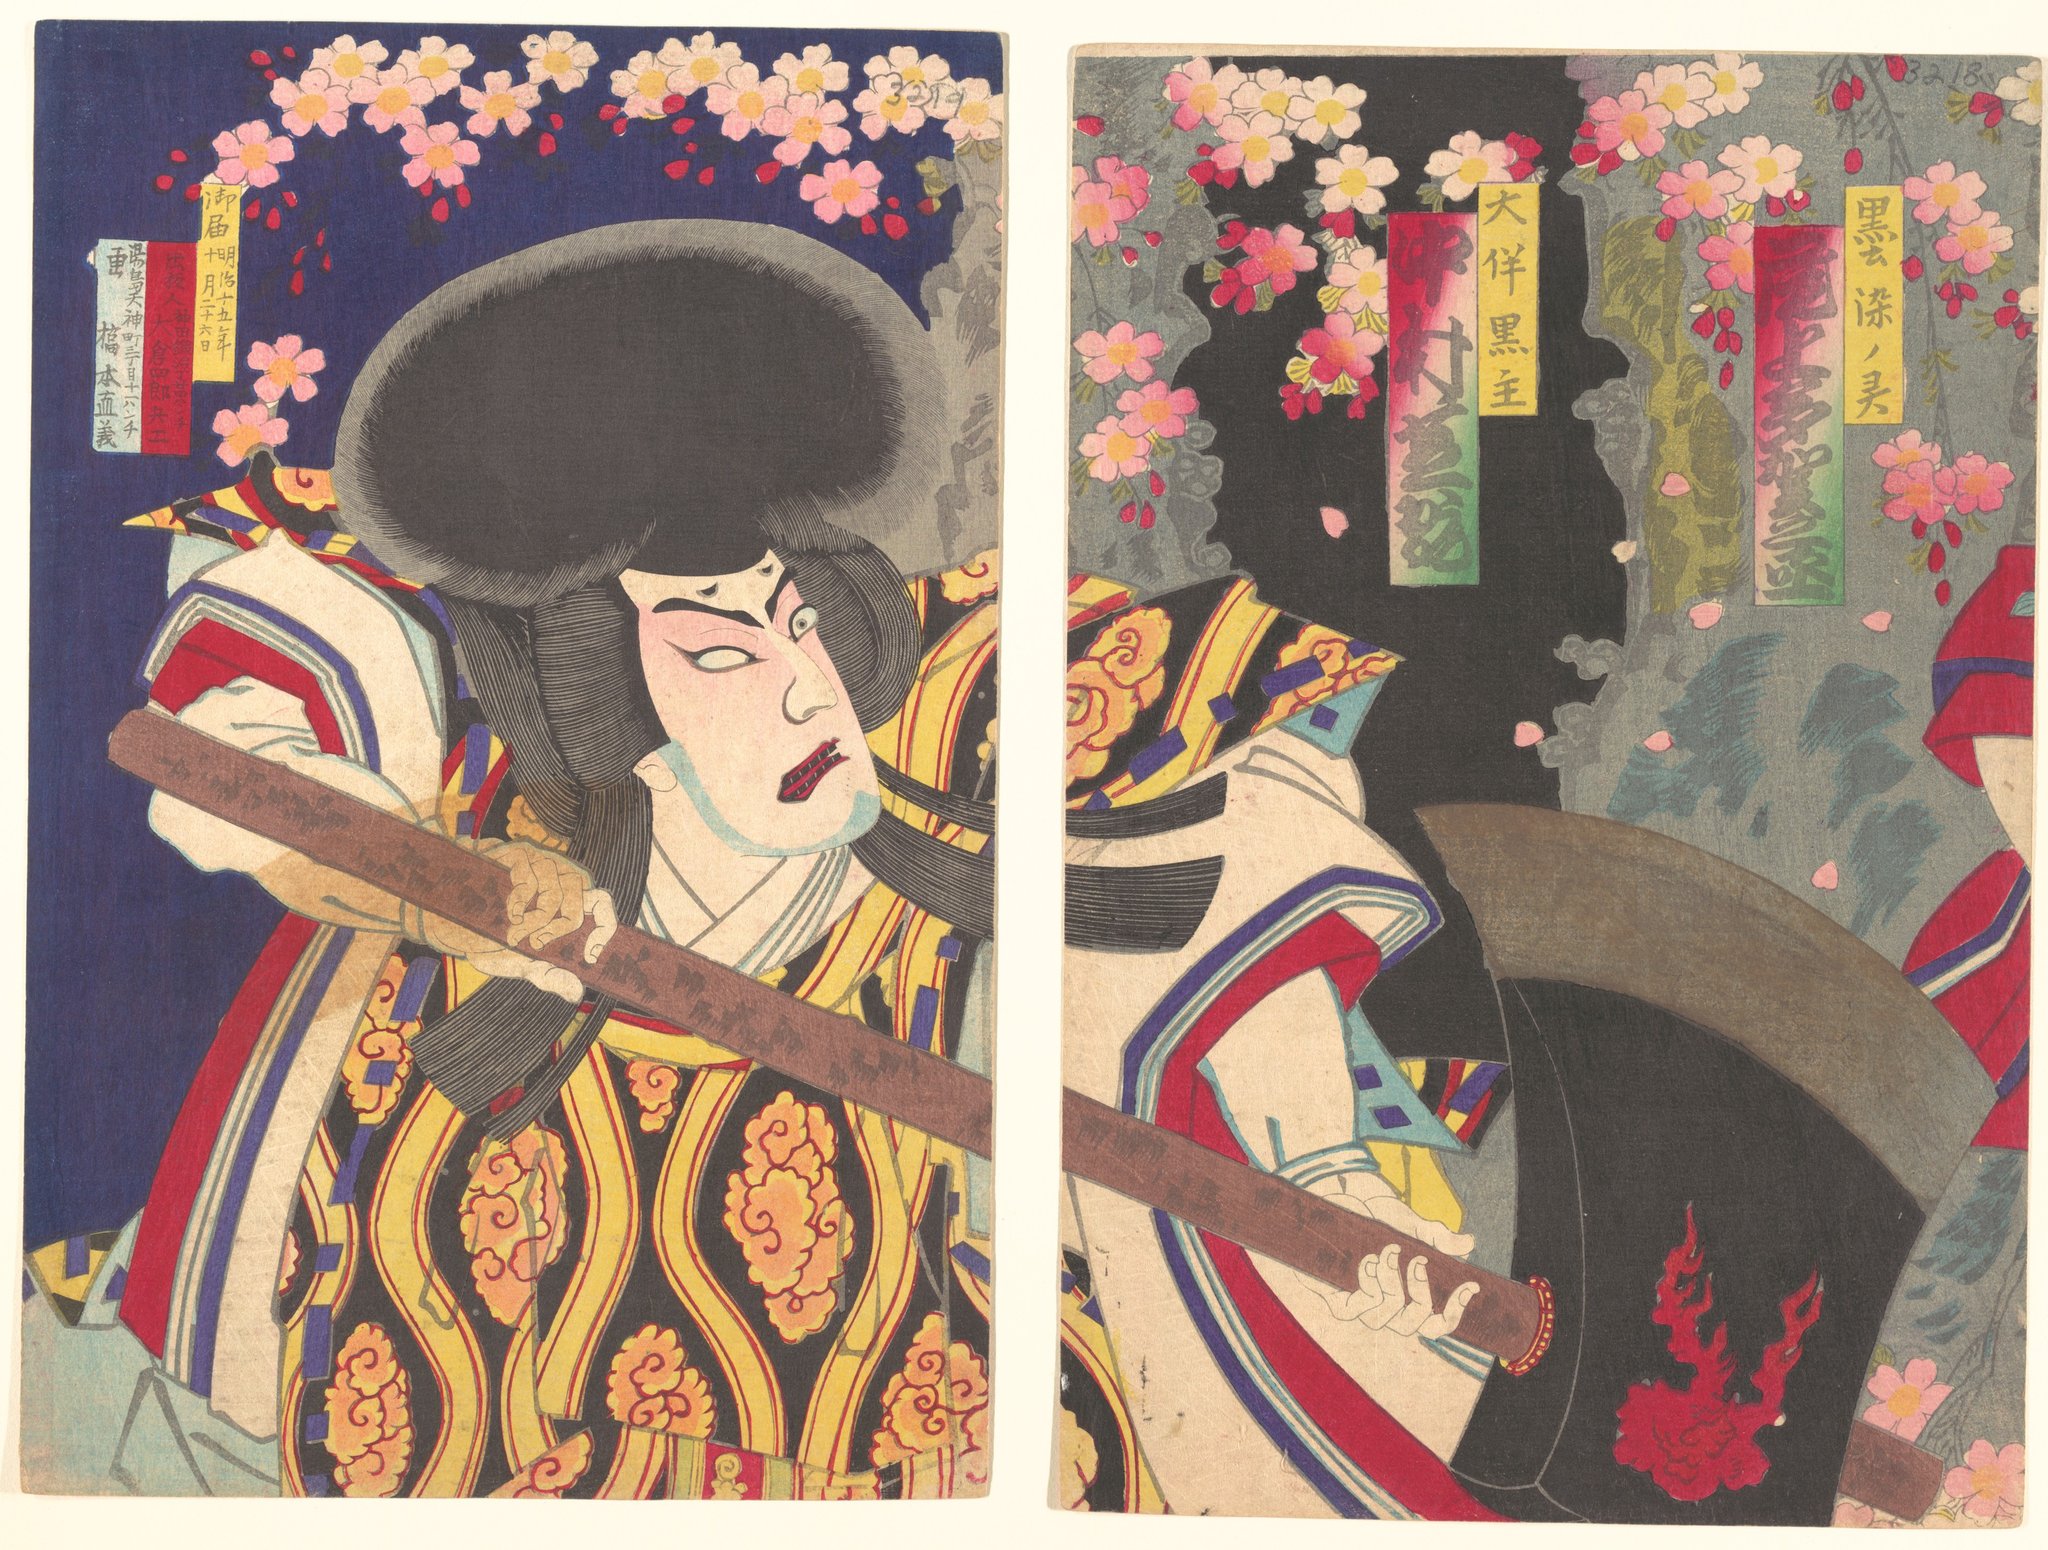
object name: print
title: Actor, Nakamura Shikan plays as Ootomo no Kuronushi, Onoe Taganojō plays as Kurosome no rei, from Tsumoru koiyuki no sekinoto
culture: japanese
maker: hashimoto naoyoshi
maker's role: artist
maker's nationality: japanese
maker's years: 1838-1912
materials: ink, panel, paper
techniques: woodblock print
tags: men,flowers,actors,axes